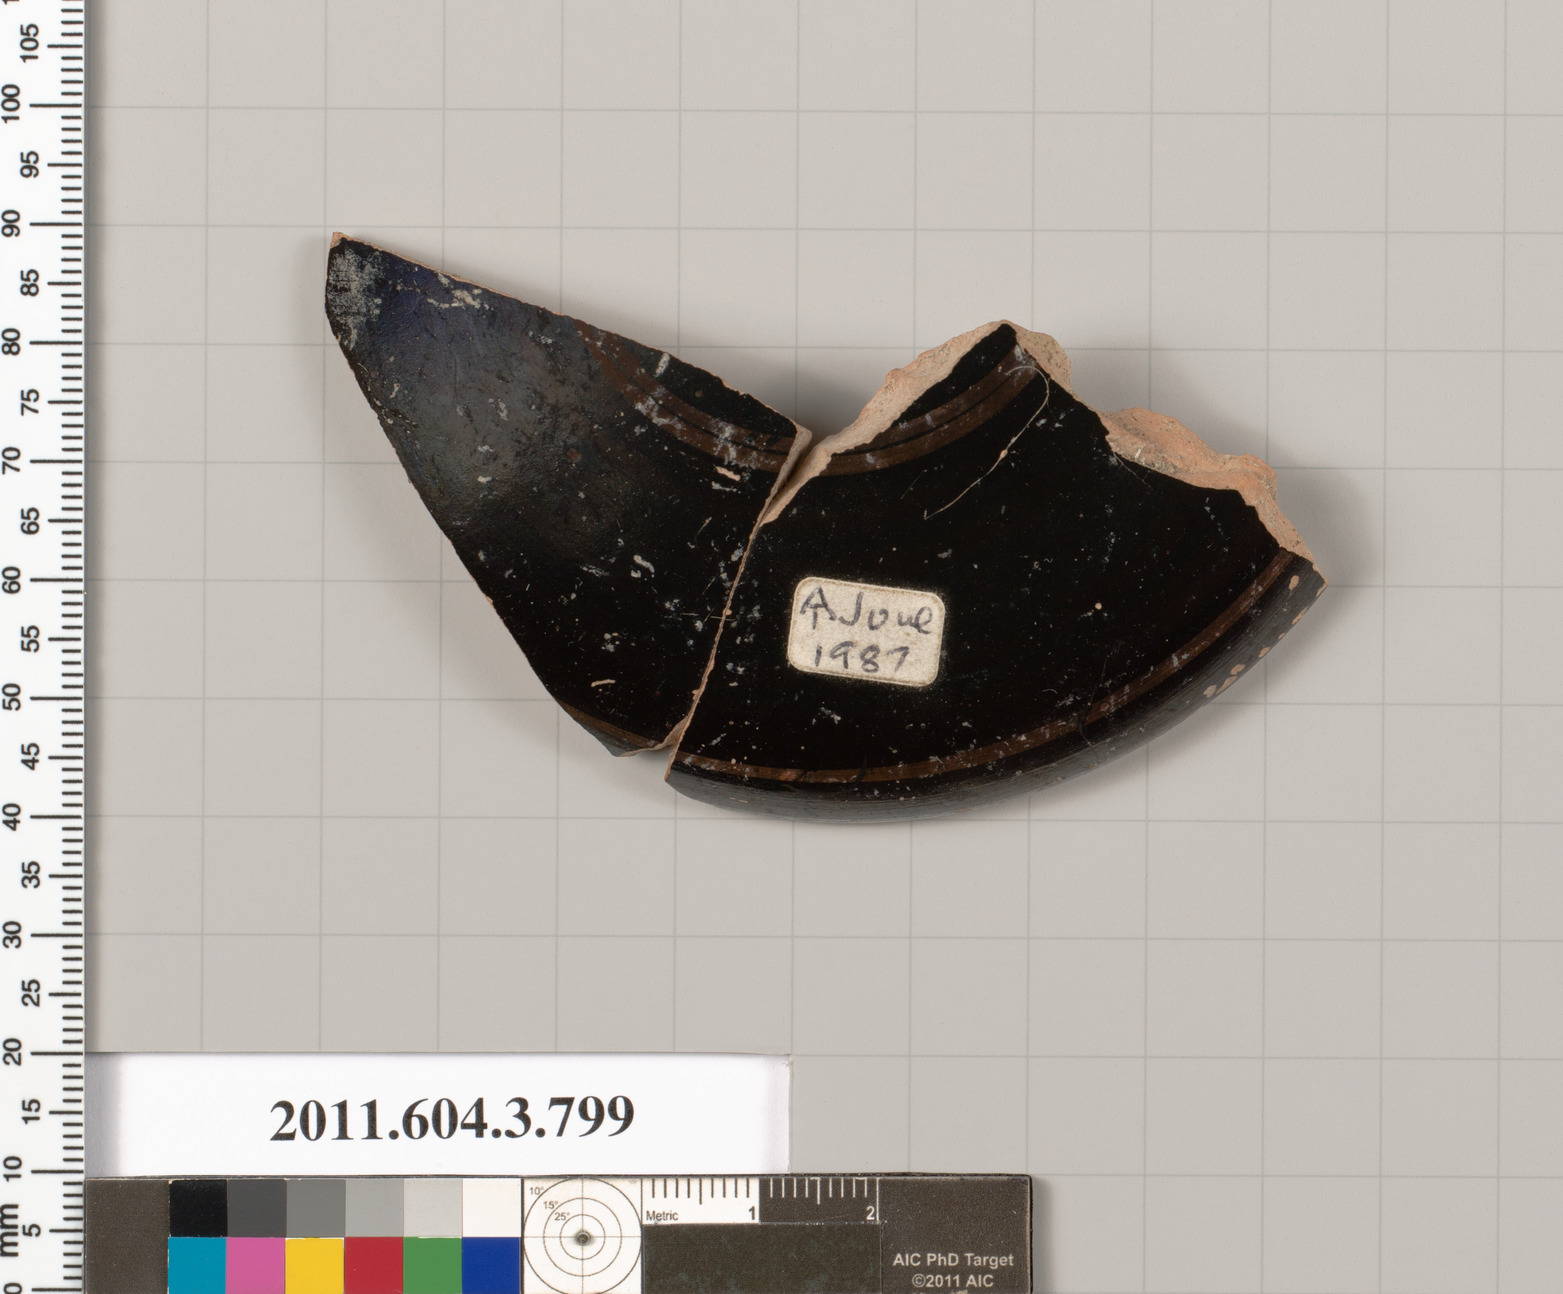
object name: lid fragment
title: Terracotta fragment of a lid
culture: greek, attic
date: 600-501 BCE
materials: terracotta